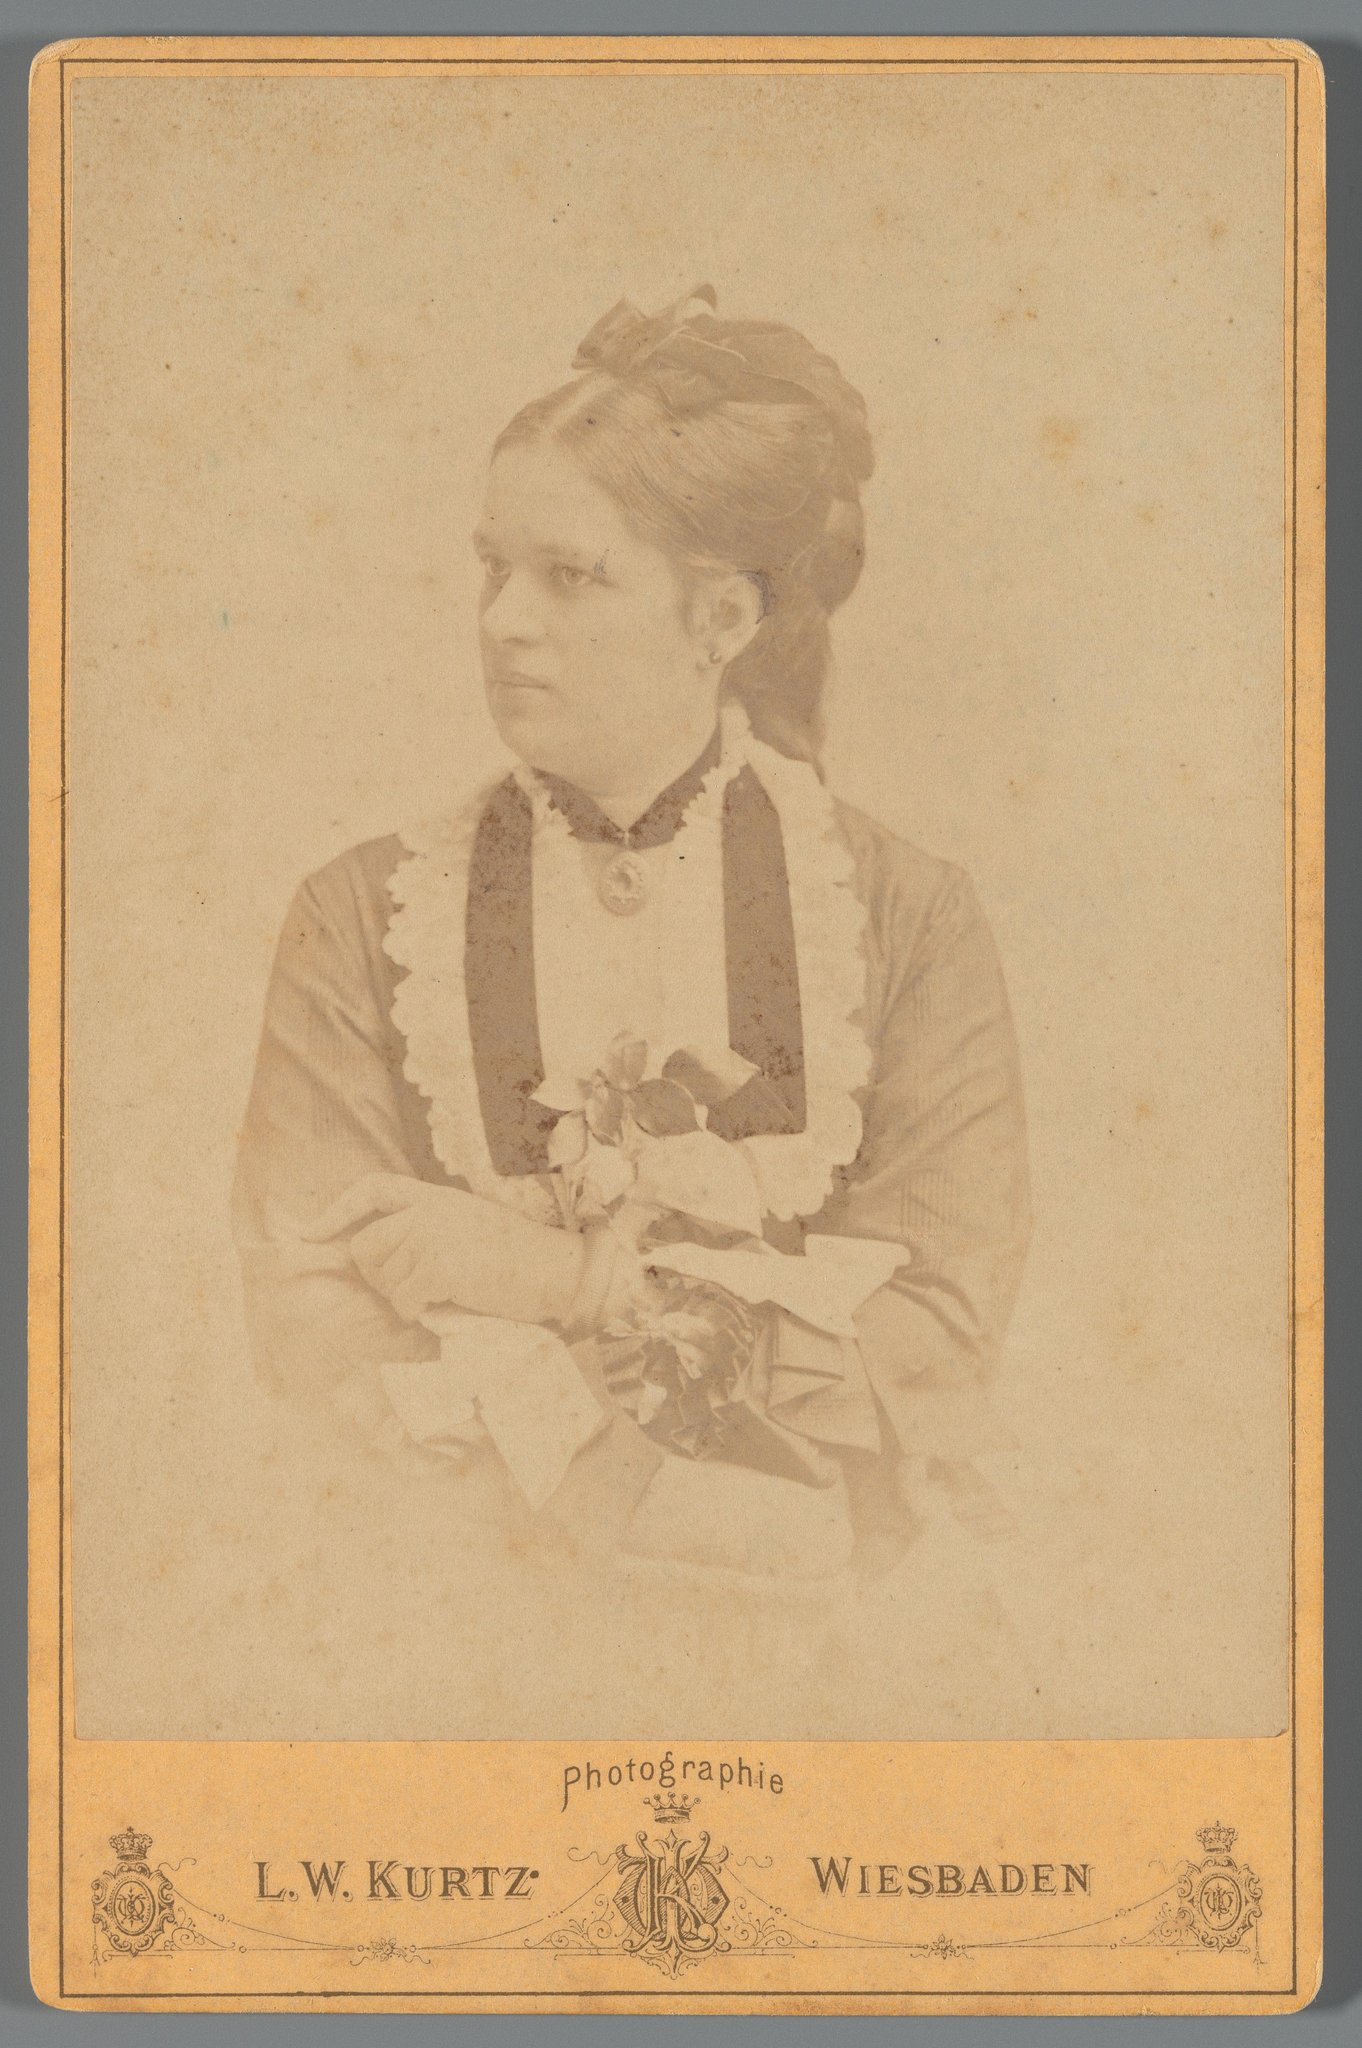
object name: cabinet photograph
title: Portret van Francina Schas met over elkaar geslagen armen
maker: leonhard w. kurtz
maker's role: fotograaf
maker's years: 1849-1906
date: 1804-1877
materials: cardboard, photographic support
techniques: albumen print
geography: wiesbaden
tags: francina schas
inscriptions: name: ‘Voor Jet en ... / April 77’, name: ‘Françoise W.S. vdBerg-Schas’, name: ‘Photographie / L.W. KURTZ WIESBADEN’